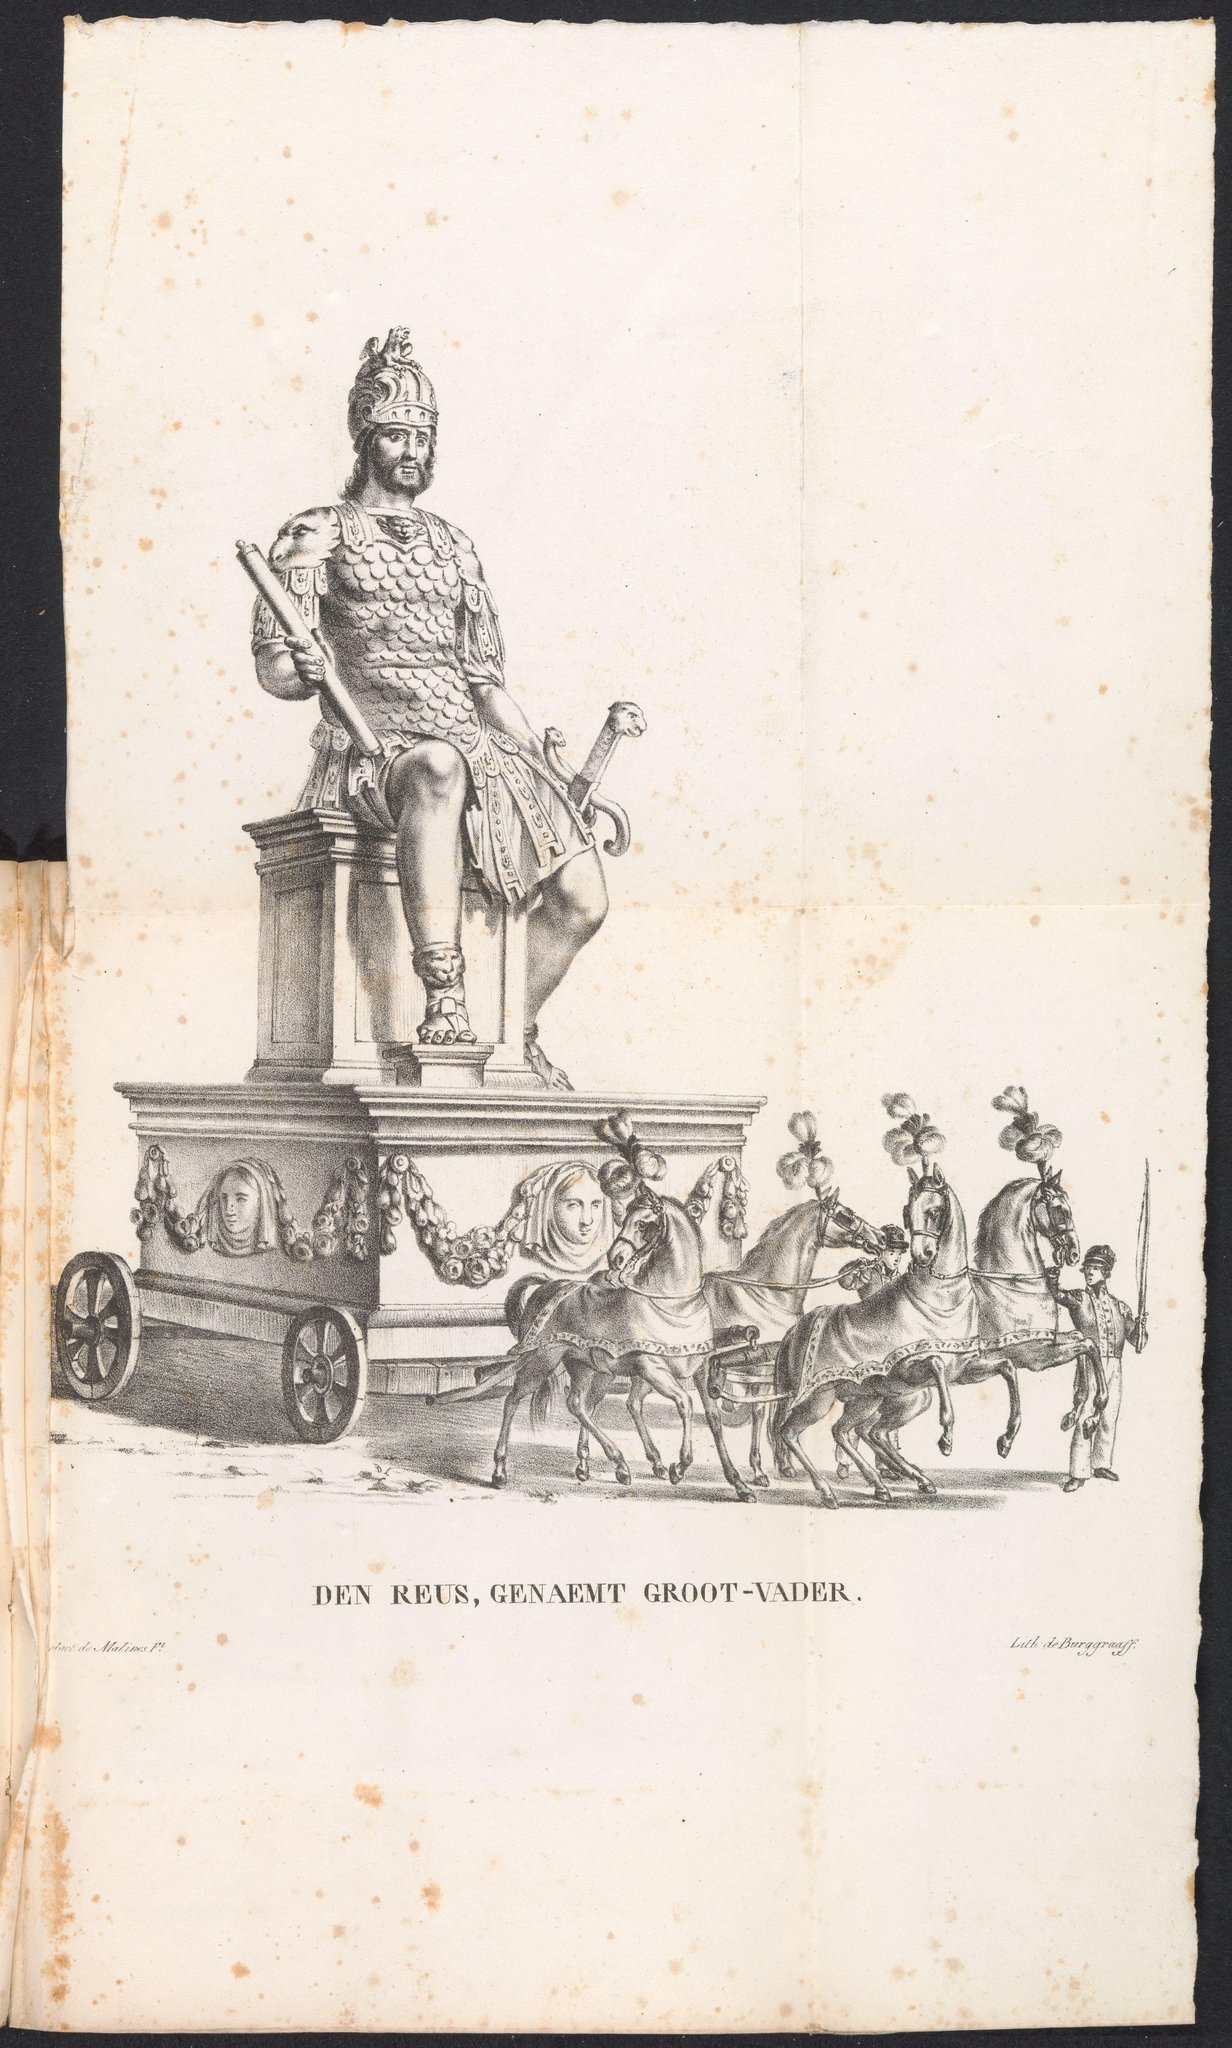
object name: print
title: Den Reuse, genaemt Groot-Vader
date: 1825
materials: paper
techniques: lithograph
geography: brussels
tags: rejoicing on special occasions (+ parade, pageant, cavalcade ~ festive activities), the hermit, martyr, and possibly former bishop of dublin, rum(b)old (rombaut) of malines; possible attributes: axe, hoe - post-mortem occurrences ~ male saint, procession ~ christian religion, giants, colossi, mechelen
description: Praalwagen met de reus genaamd Grootvader, een zittend krijgsman in antieke wapenrusting. Onderdeel van de reuzenfamilie. De wagen getrokken door vier paarden. Onderdeel van de ommegang voor de Heilige Rombout. De optocht werd gehouden op 28 juni, 5 en 12 juli 1825. Illustratie in een publicatie ter gelegenheid van de 1050-jarige viering in 1825 van de dood van de Heilige Rumoldus of Rombout, patroonheilige van de stad Mechelen, van wie werd gedacht dat hij in 775 was overleden.